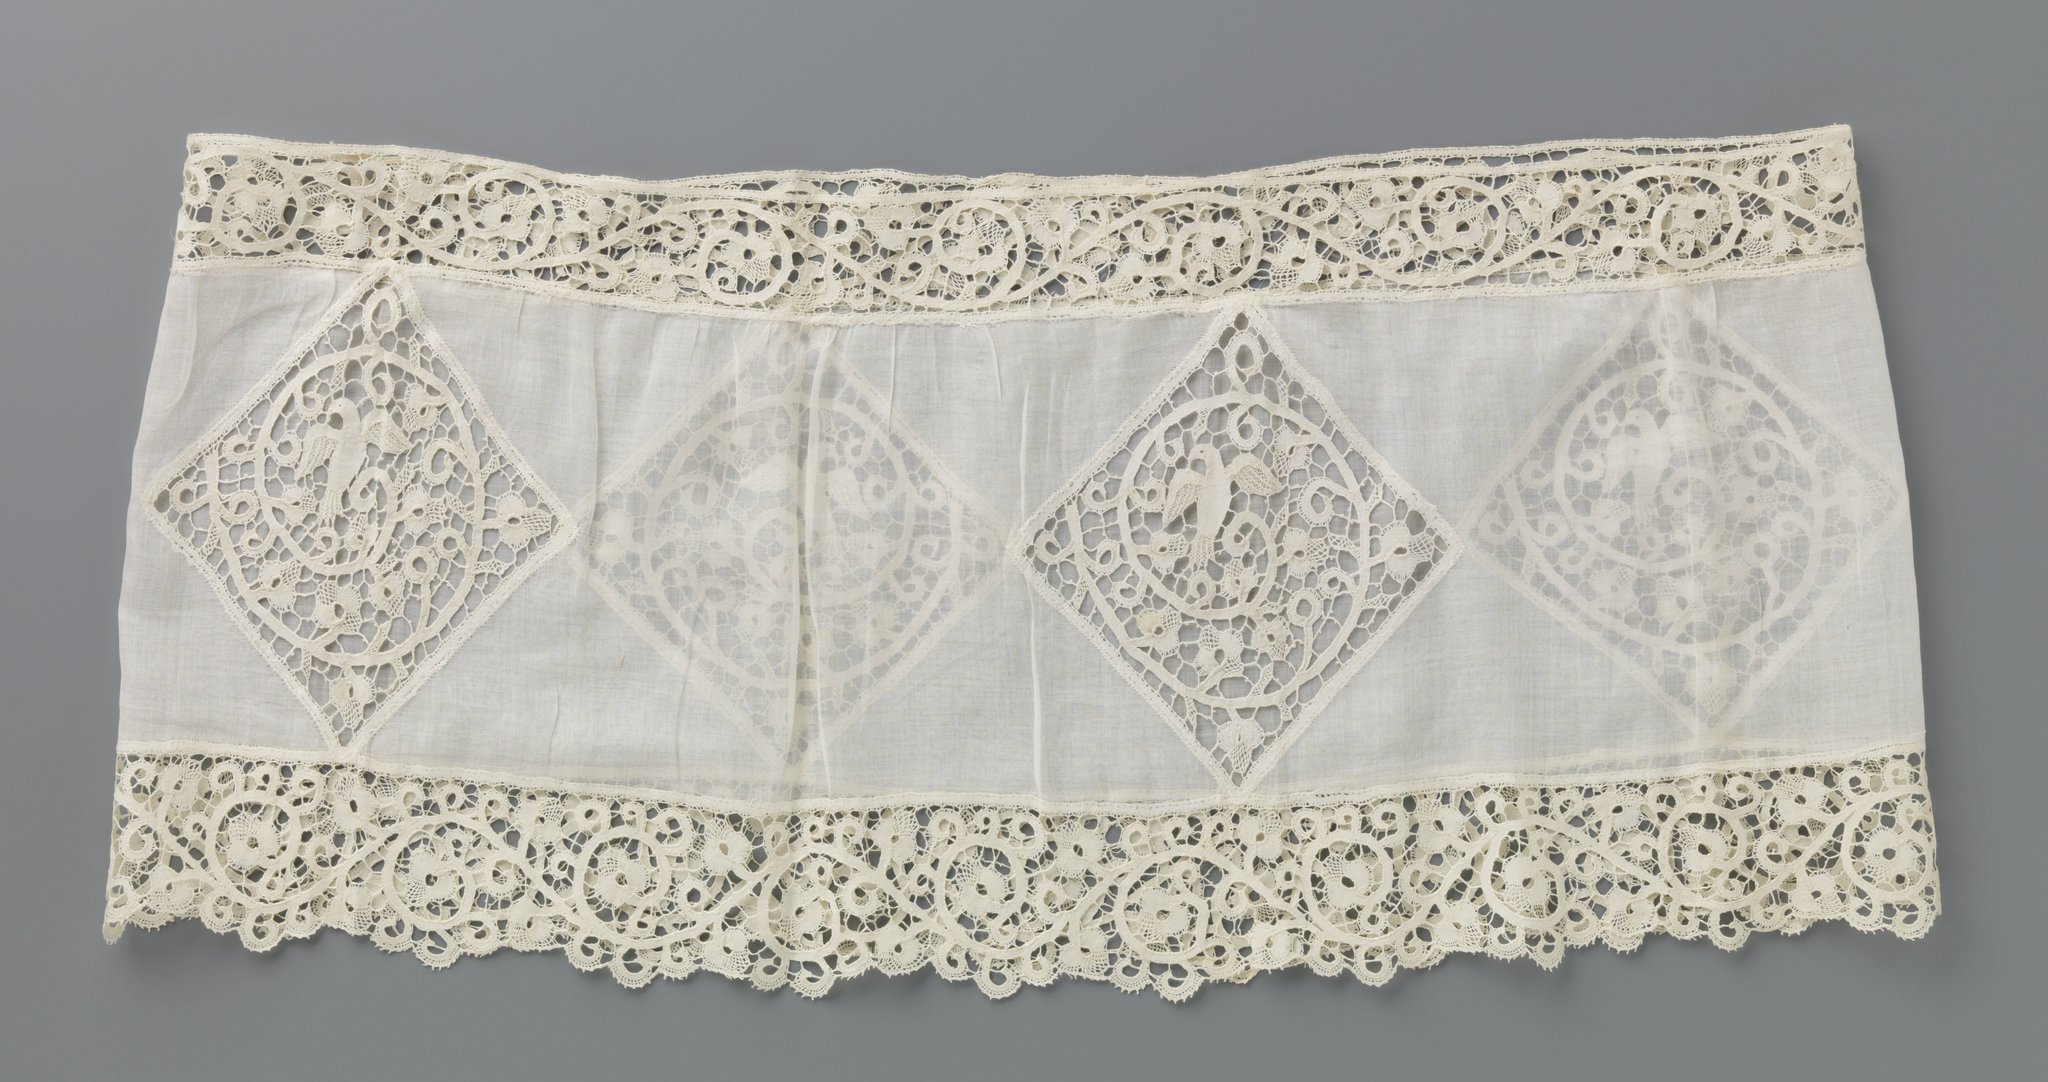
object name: kap onderdeel van verlichtingsmiddelen, lampenkap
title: Lampenkap van kloskant met vogels op spiraal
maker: Anonymous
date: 1900-1924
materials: linen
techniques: lace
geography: italy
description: Een batisten, rondlopend middendeel heeft vier ingezette ruiten, een entre-deux aan de bovenzijde en een schulpstrook onderaan. Een fond van spijlen vertoont lopende spiraalranken. Iedere ruit heeft een enkele, grote spiraal, waarop een vogel met gespreide vleugels zit. De stroken vertonen ranken met op- en neergaande spiralen, waaraan eikelvormige bloemknopjes en hechtrrankjes groeien. Kloskant, mogelijk Cantu-kant.